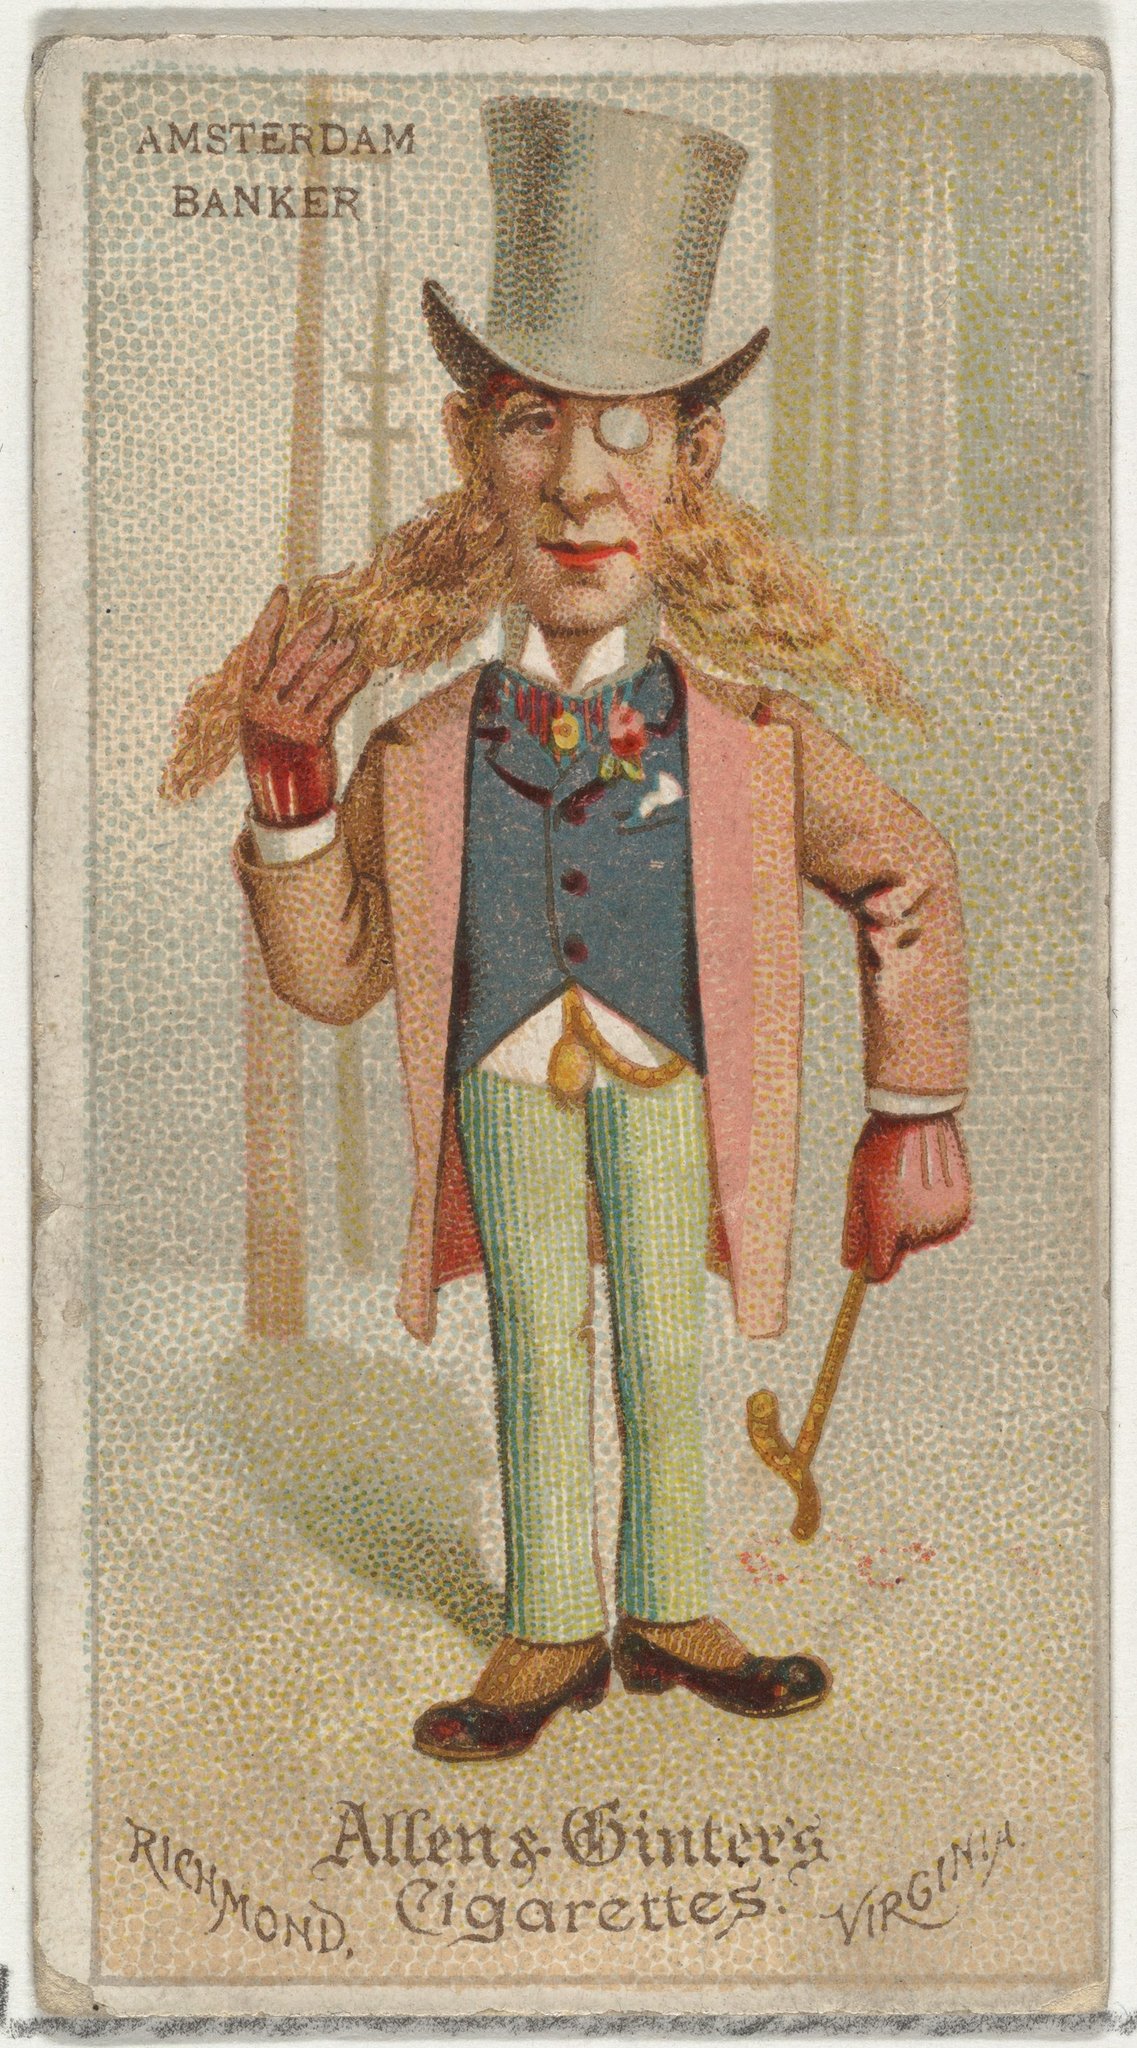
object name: print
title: Amsterdam Banker, from World's Dudes series (N31) for Allen & Ginter Cigarettes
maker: allen & ginter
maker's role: publisher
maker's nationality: american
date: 1888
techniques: color lithograph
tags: men